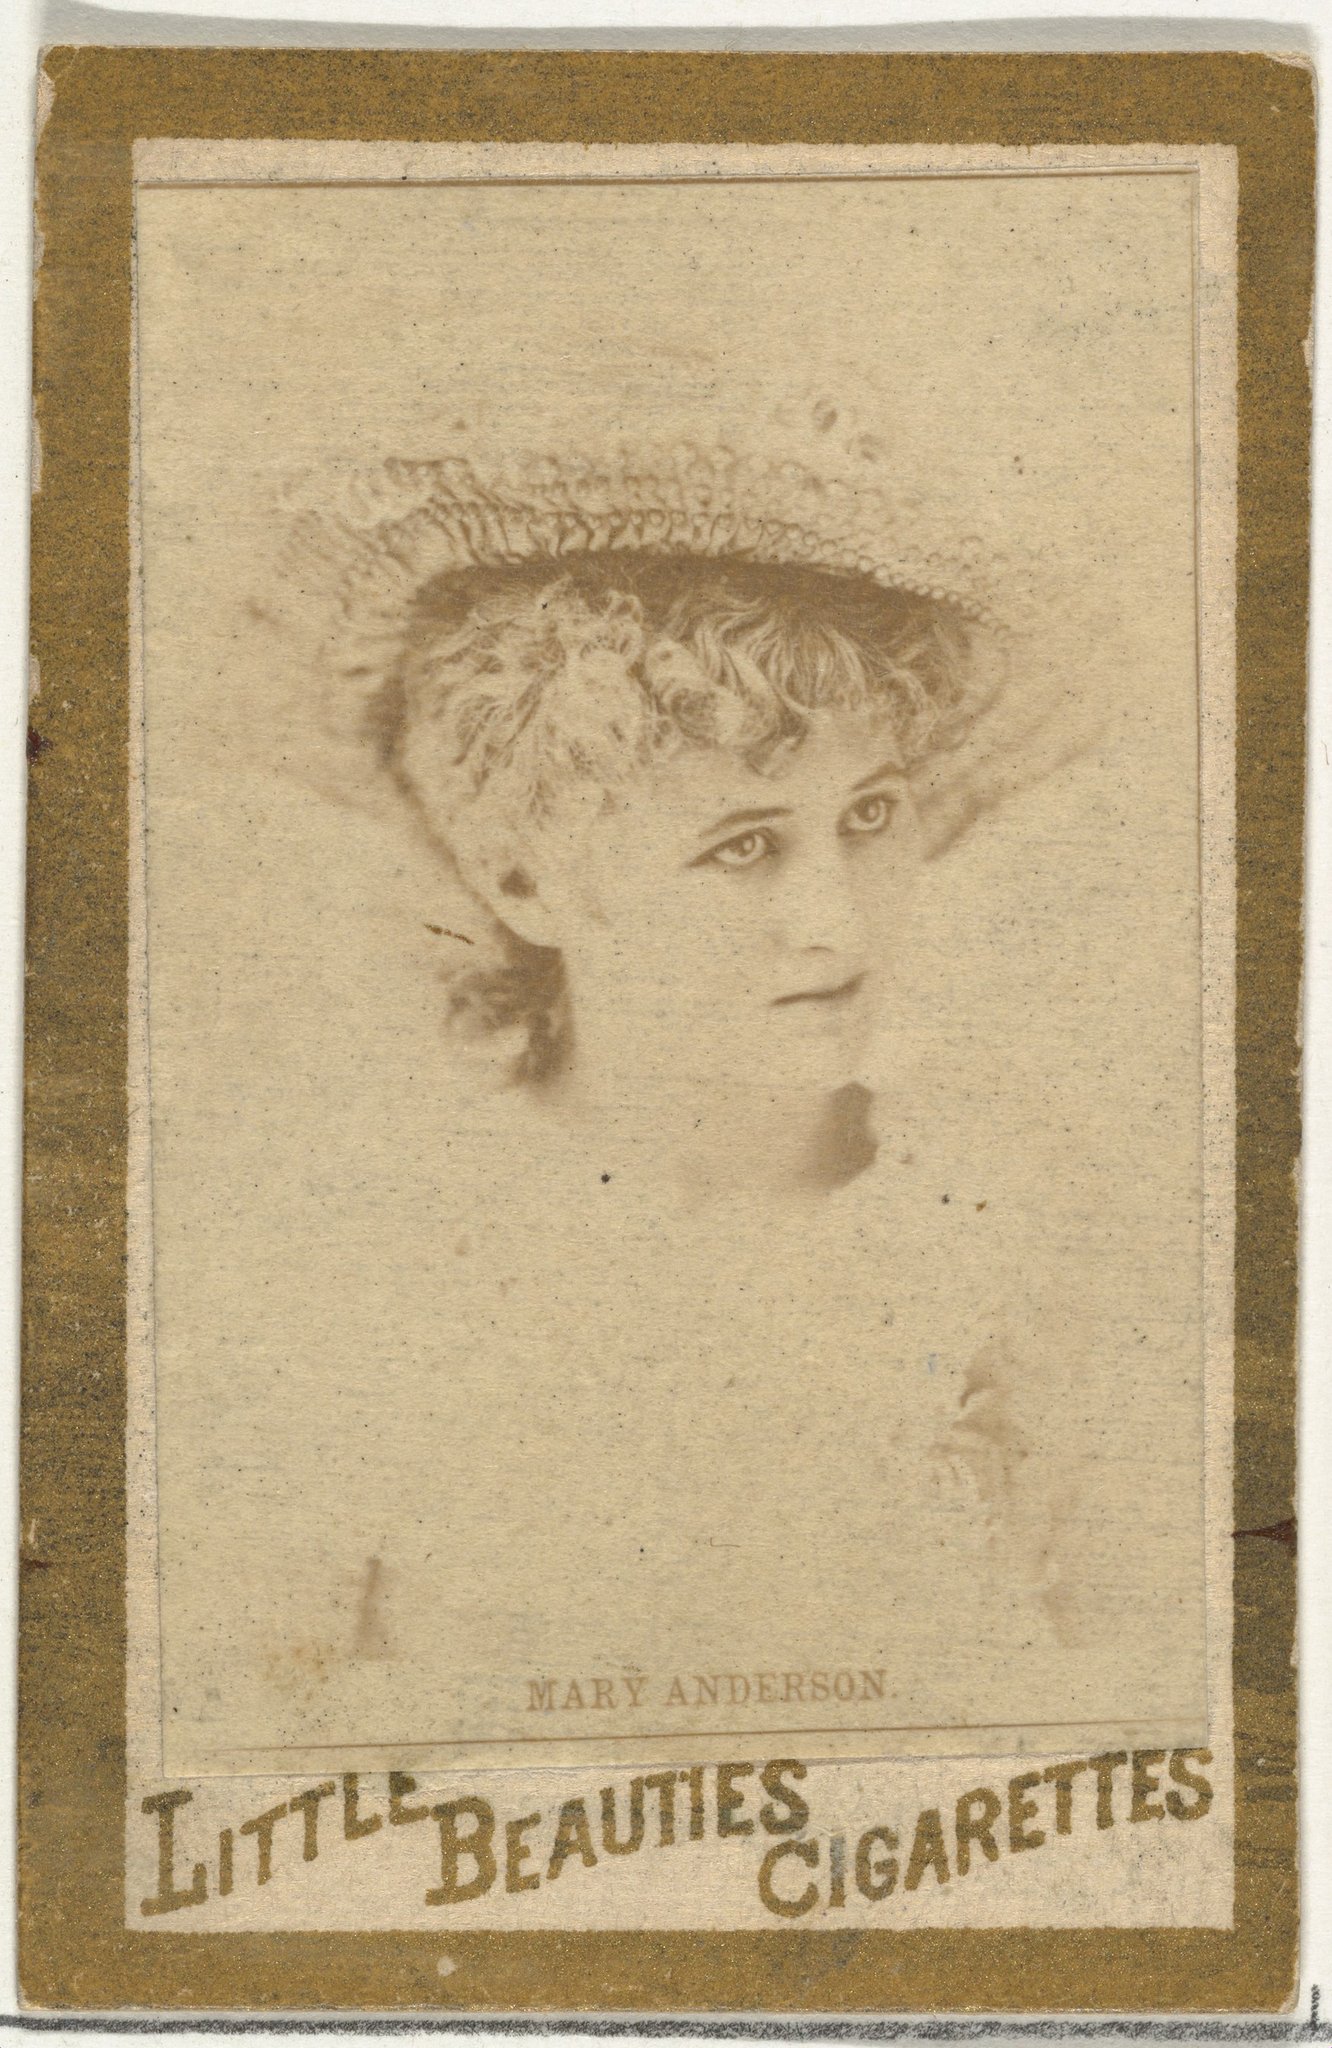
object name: photograph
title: Mary Anderson, from the Actresses and Celebrities series (N60, Type 1) promoting Little Beauties Cigarettes for Allen & Ginter brand tobacco products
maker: allen & ginter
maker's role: publisher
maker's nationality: american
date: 1887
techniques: albumen silver print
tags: portraits,women,actresses